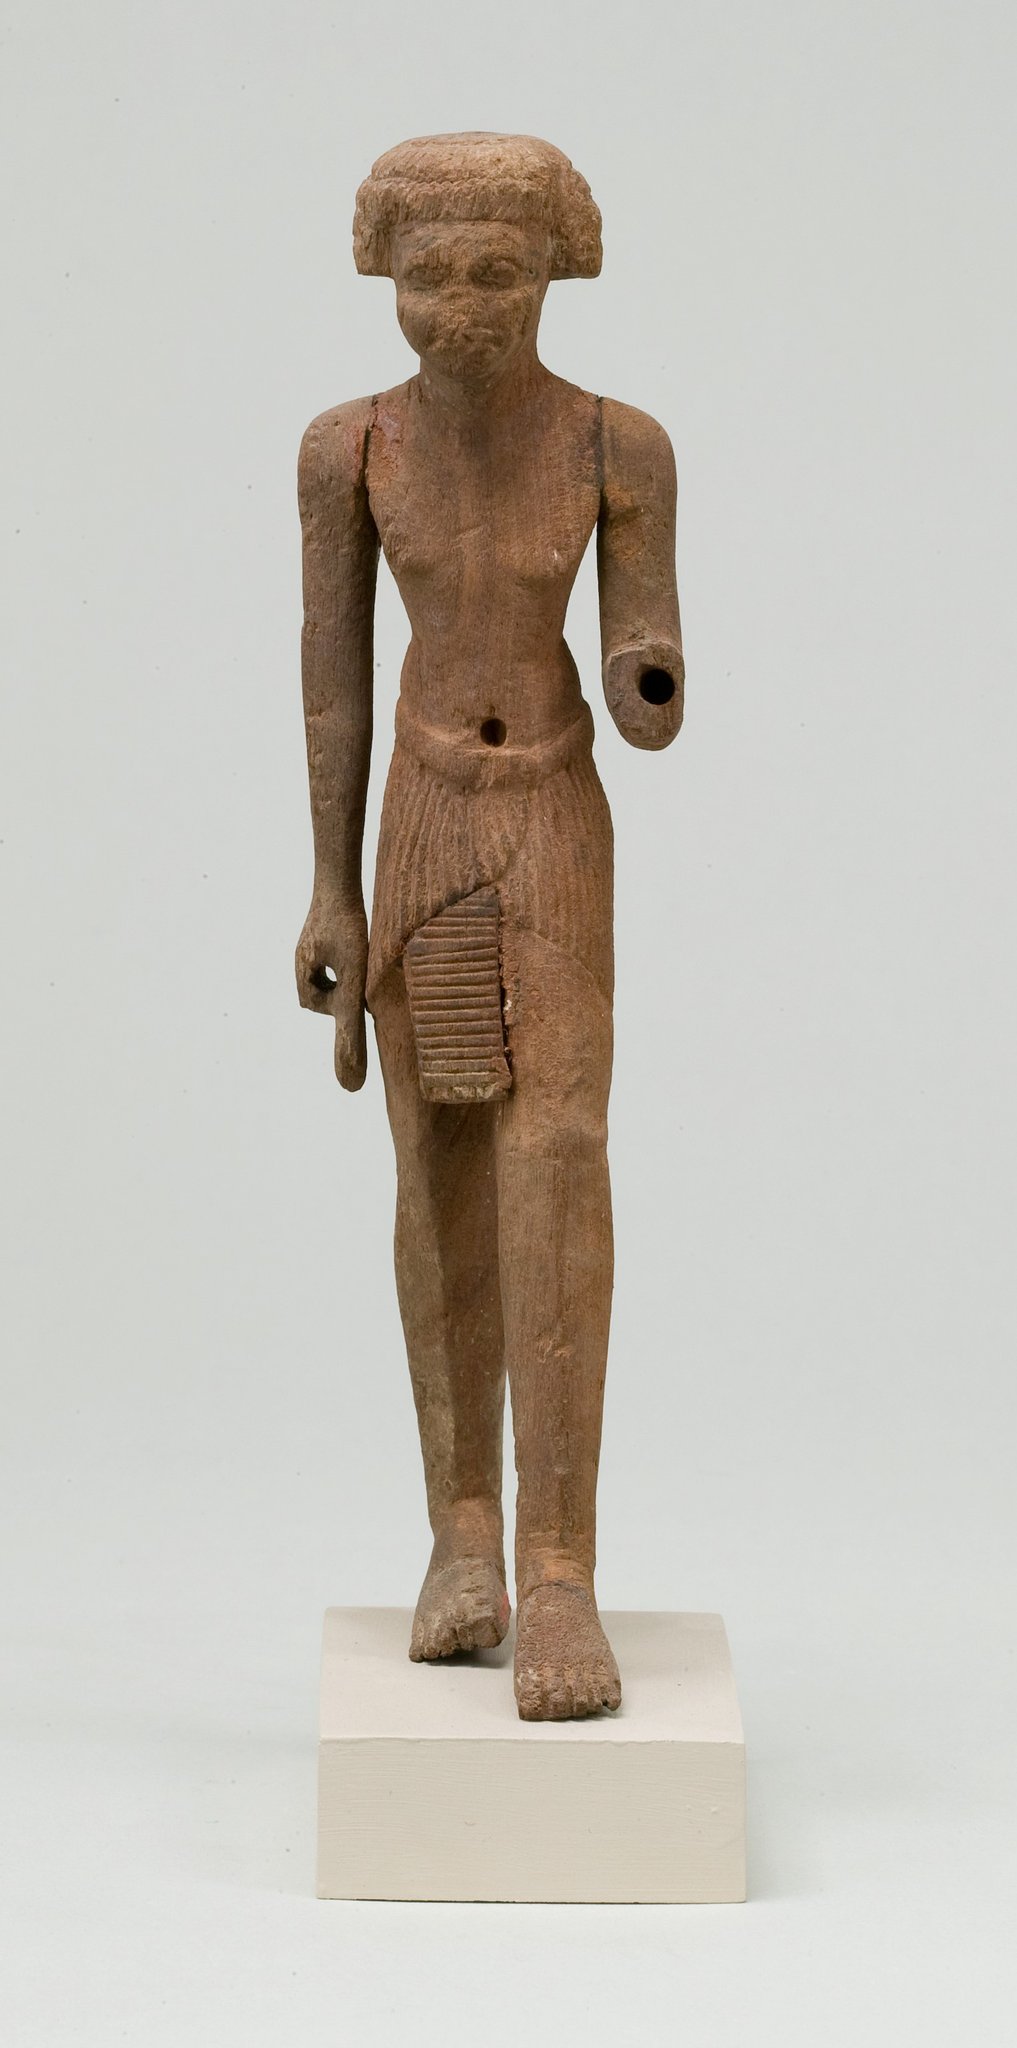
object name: statuette, striding man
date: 1635-1458 BCE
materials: wood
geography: egypt